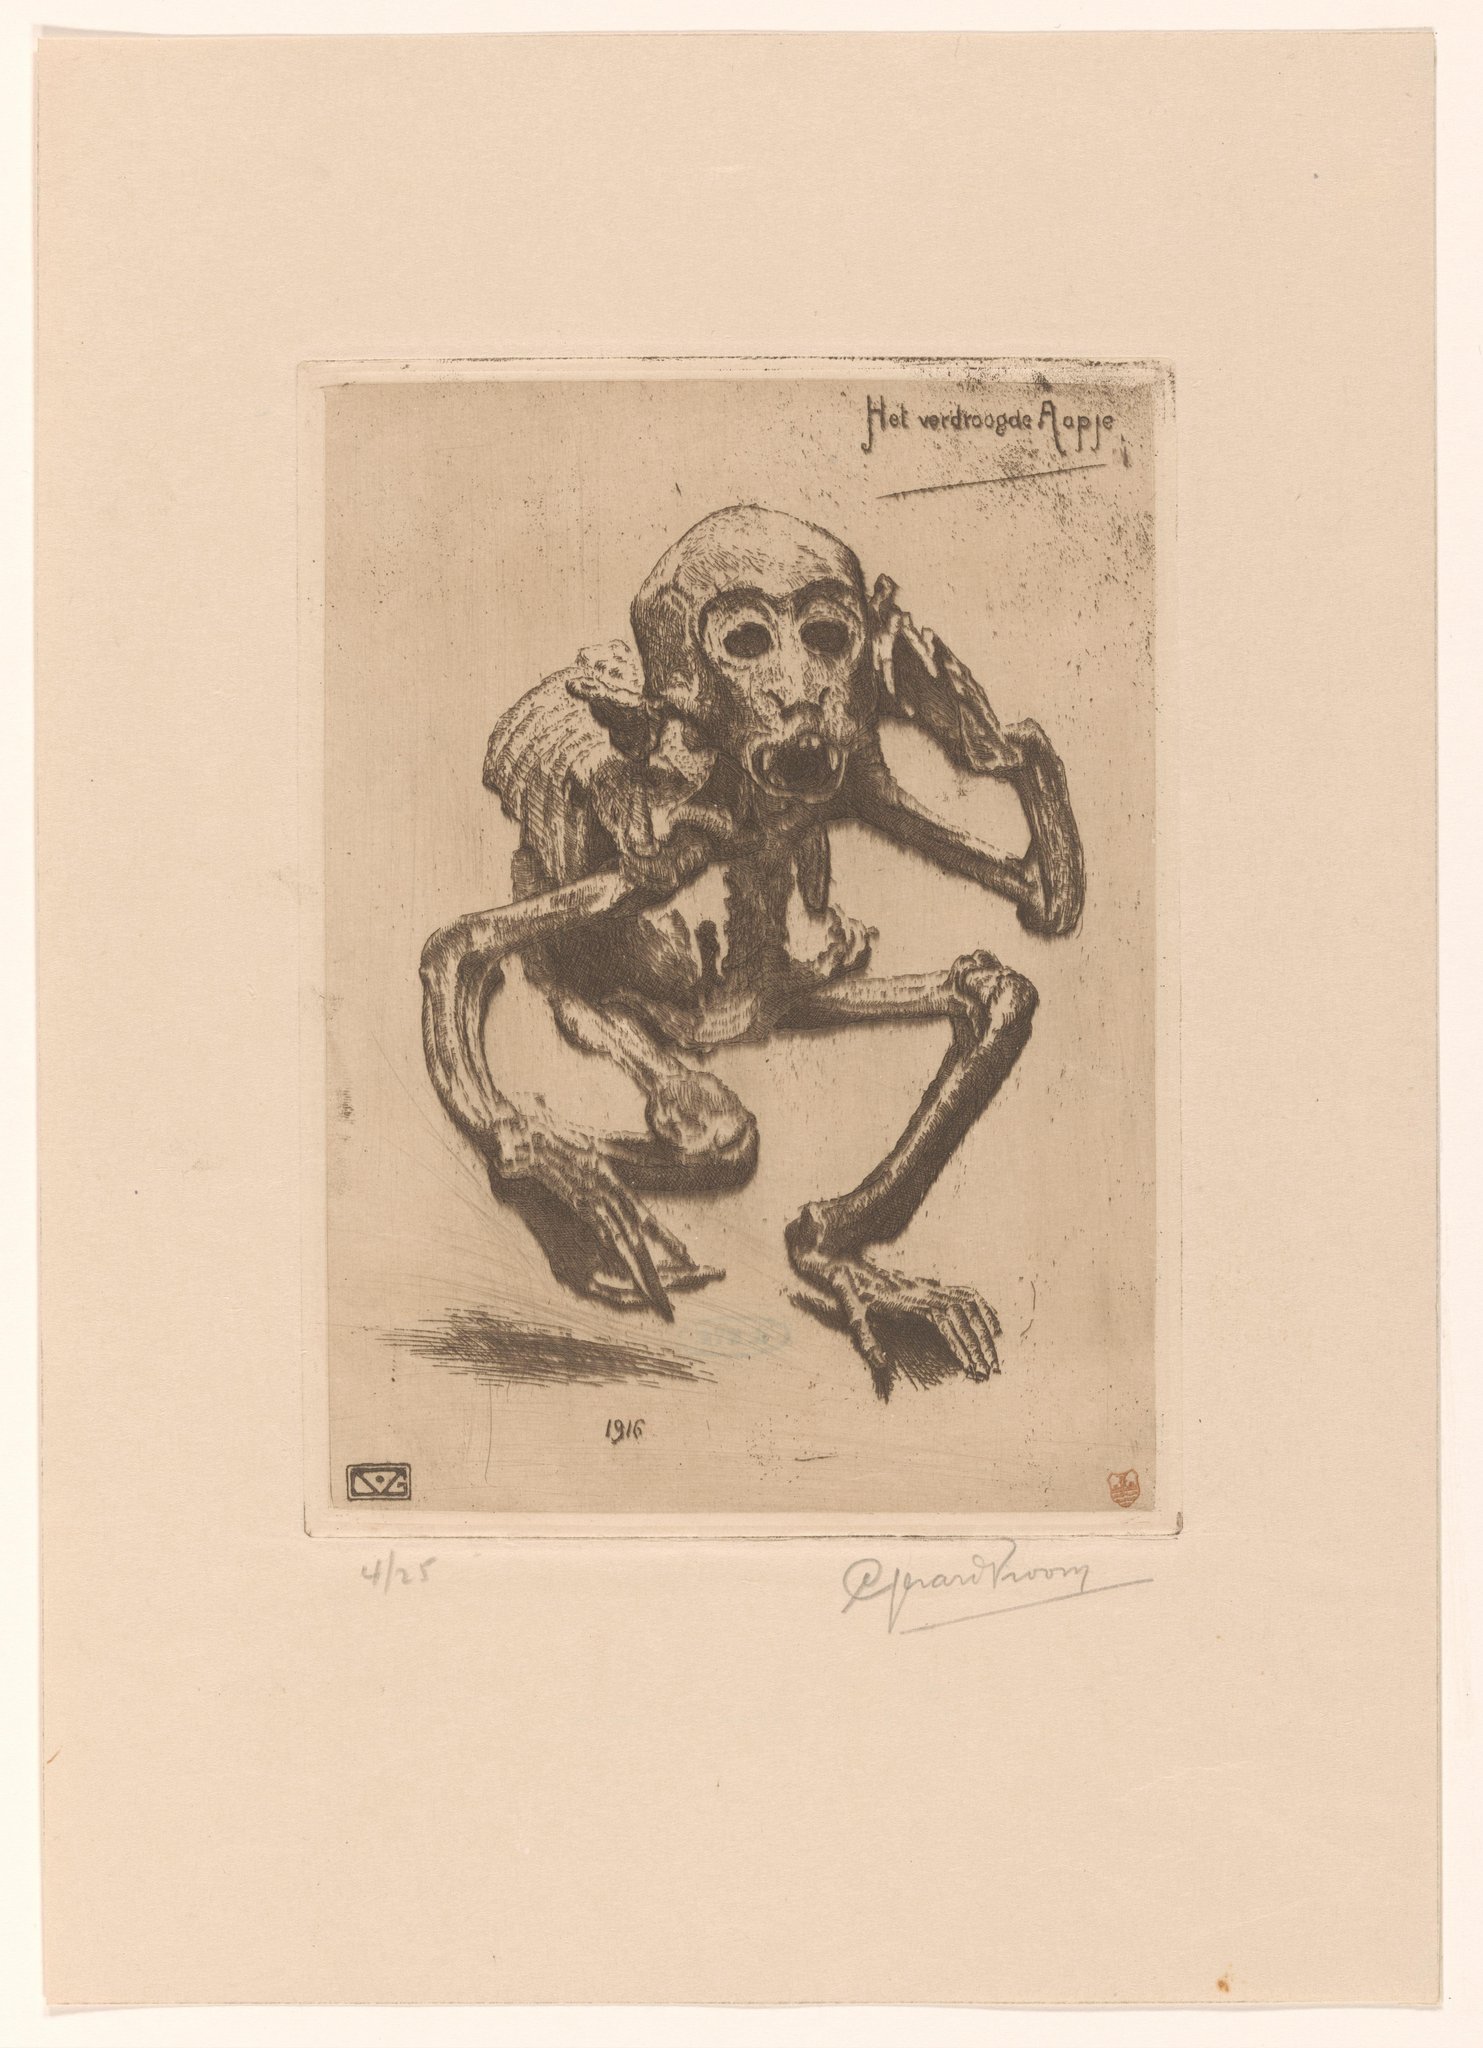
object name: print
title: Het verdroogde aapje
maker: gerard vroom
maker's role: print maker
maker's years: 1888-1945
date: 1916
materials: paper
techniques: drypoint, etching, intaglio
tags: monkeys, apes, (human) skeleton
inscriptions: collector's mark: Lugt 2228, collector's mark: Lugt 2760